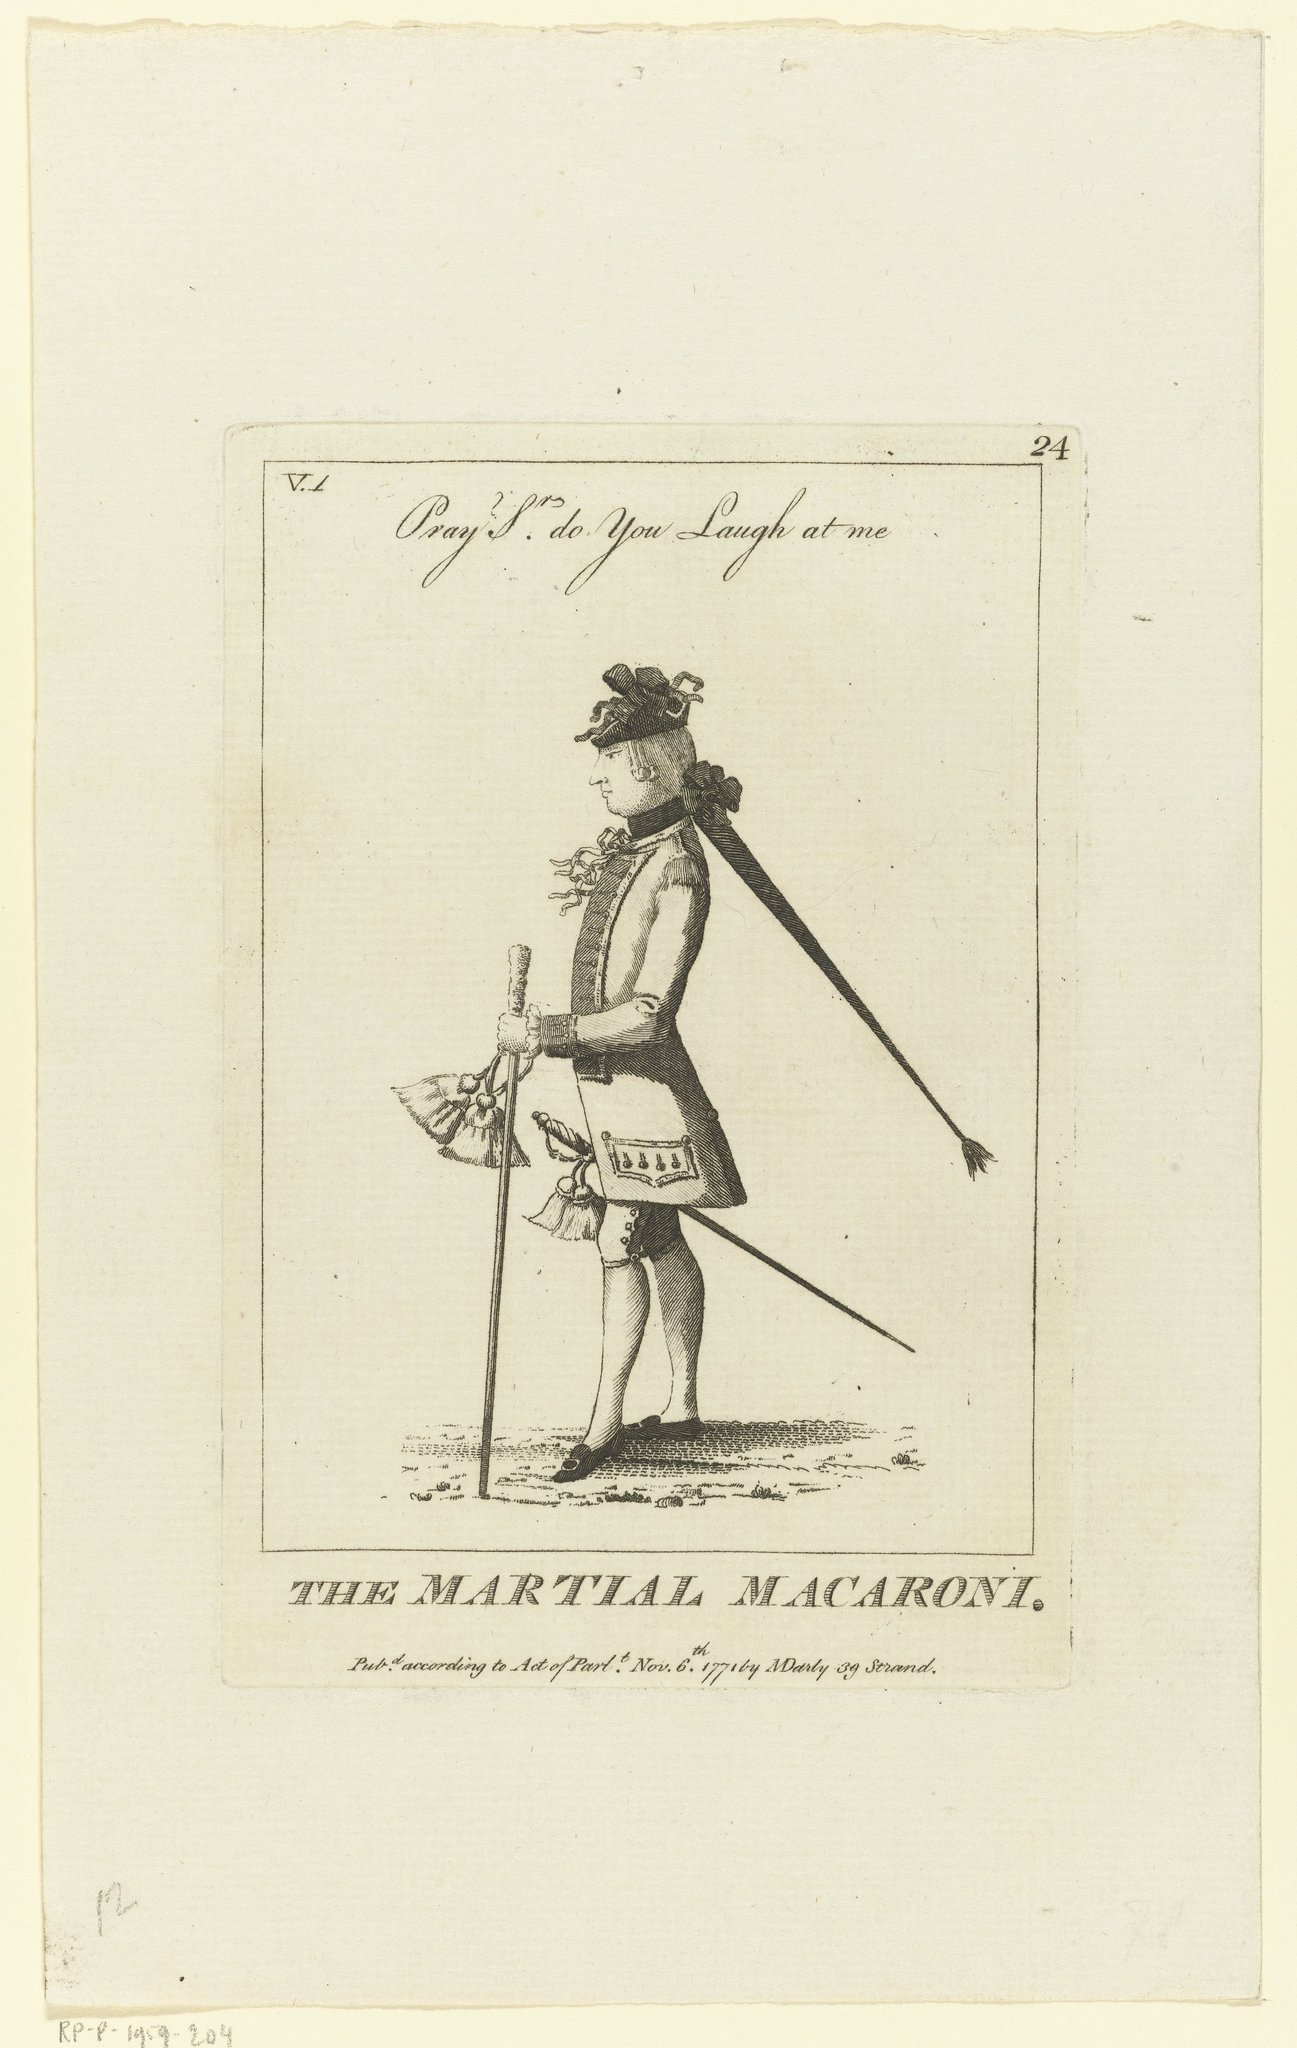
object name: cartoon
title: The Martial Macaroni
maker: matthew darly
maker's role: print maker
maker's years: 1720-1780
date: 1771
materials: paper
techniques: etching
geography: london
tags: dandy, beau, hacking and thrusting weapons, coat (+ men's clothes), head-gear: hat (+ men's clothes), styles of hairdress, trousers, breeches, etc. (breeches) (+ men's clothes), walking-stick, staff, cane (+ men's clothes)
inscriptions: inscription: ‘Pray S.rs do you Laugh at me’, caption: ‘THE MARTIAL MACARONI. / Pub.d according to Act of Parl.t Nov. 6.th 1771 by MDarly 39 Strand.’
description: Linksboven V.1; rechtsboven nummer 24. Engelse caricaturen uit de serie 'Macaronies' uitgegeven door D. Marly in 1771 en 1772.